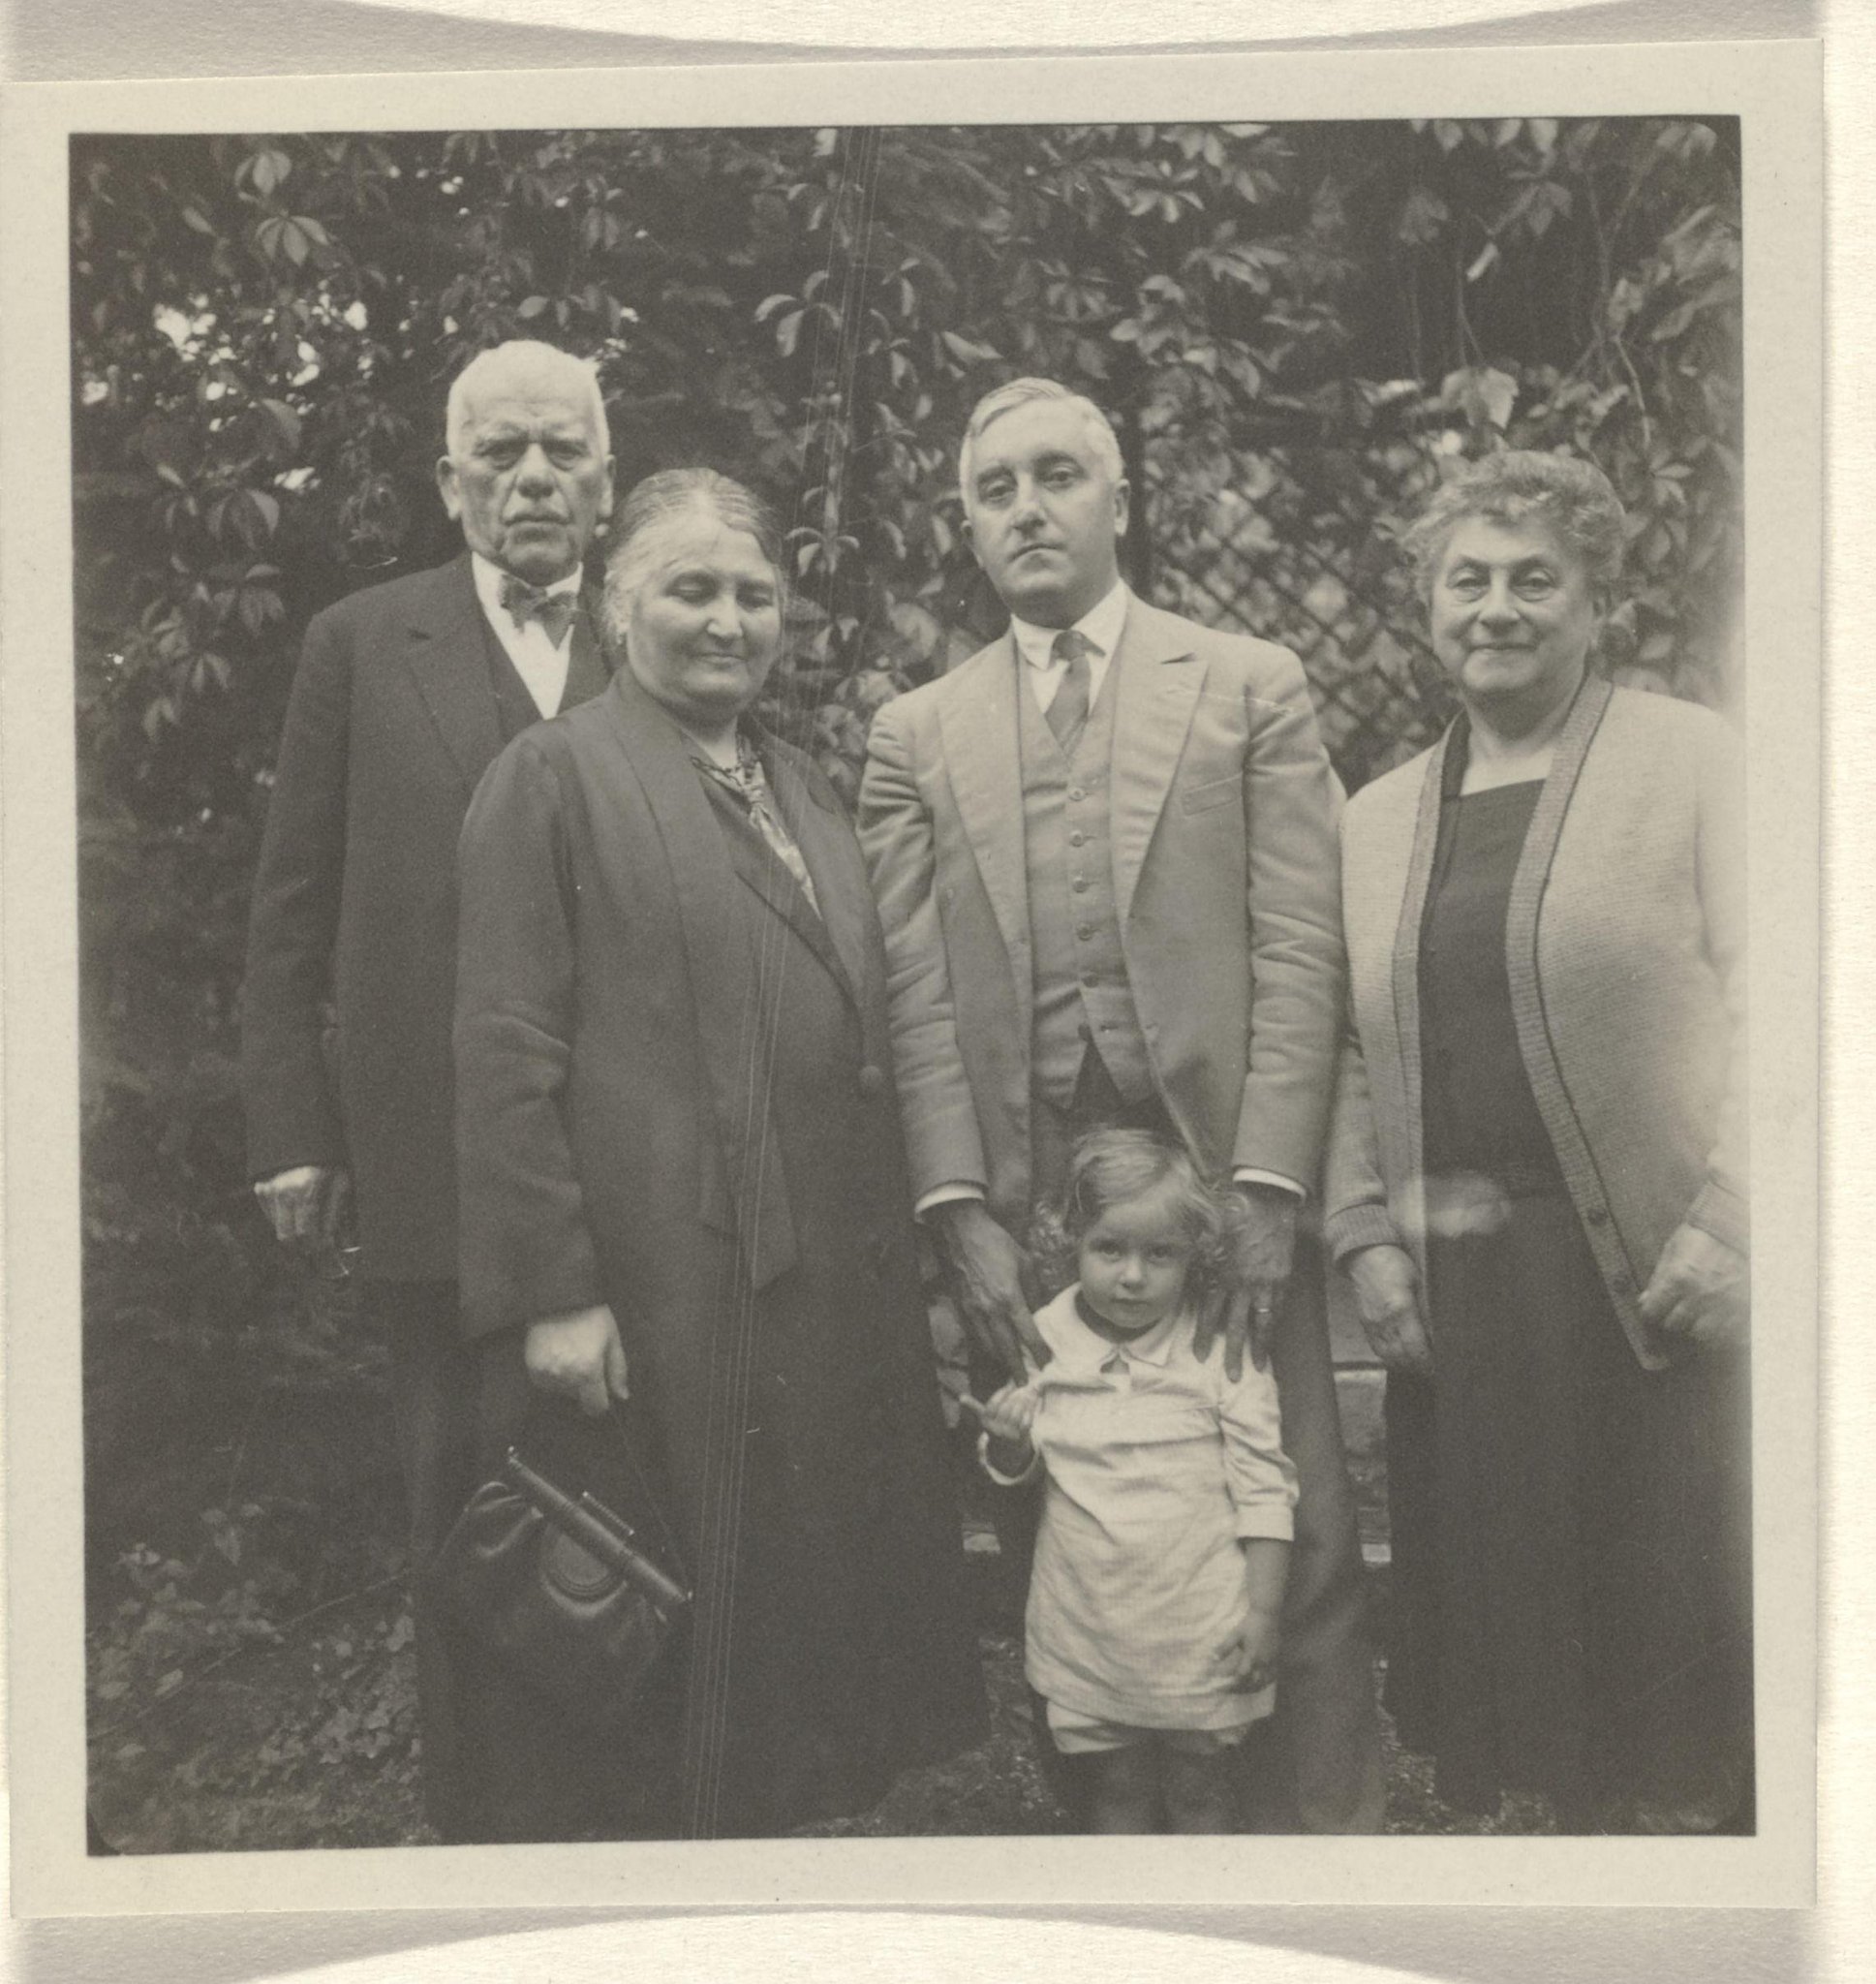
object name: photograph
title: Meir Wachenheimer, Mathilde Wachenheimer-Wertheimer, Eugen Wachenheimer, Josefine Moos-Levi, Isabel Wachenheimer in tuin in Stuttgart, 6 tot 13 september 1930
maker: Anonymous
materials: photographic support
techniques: gelatin silver print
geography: stuttgart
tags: eugen wachenheimer, leiden, isabel wachenheimer-elon, josefine moos-levi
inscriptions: number: ‘f63m’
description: Dit object is onderdeel van de nalatenschap van Isabel Elon-Wachenheimer (1928-2010). Tot haar overlijden behoorde het samen met de andere objecten uit de nalatenschap tot haar privédomein van Isabel Wachenheimer. In die particuliere context zijn deze objecten tezamen en individueel aandenkens - aan de jeugd, ouders en familie van Isabel Wachenheimer vóór en tijdens de Shoah en aan haar leven na de Tweede Wereldoorlog. Isabel Wachenheimer, die van juni 1943 tot mei 1945 gevangen zat in Kamp Westerbork, Theresienstadt, Auschwitz, Lenzing a/d Oberdonau (een buitenkamp van Mauthausen), overleefde de Shoah. Haar ouders – Eugène Wachenheimer en Else Wachenheimer-Moos - werden op 14 oktober 1944 in Auschwitz-Birkenau vermoord.